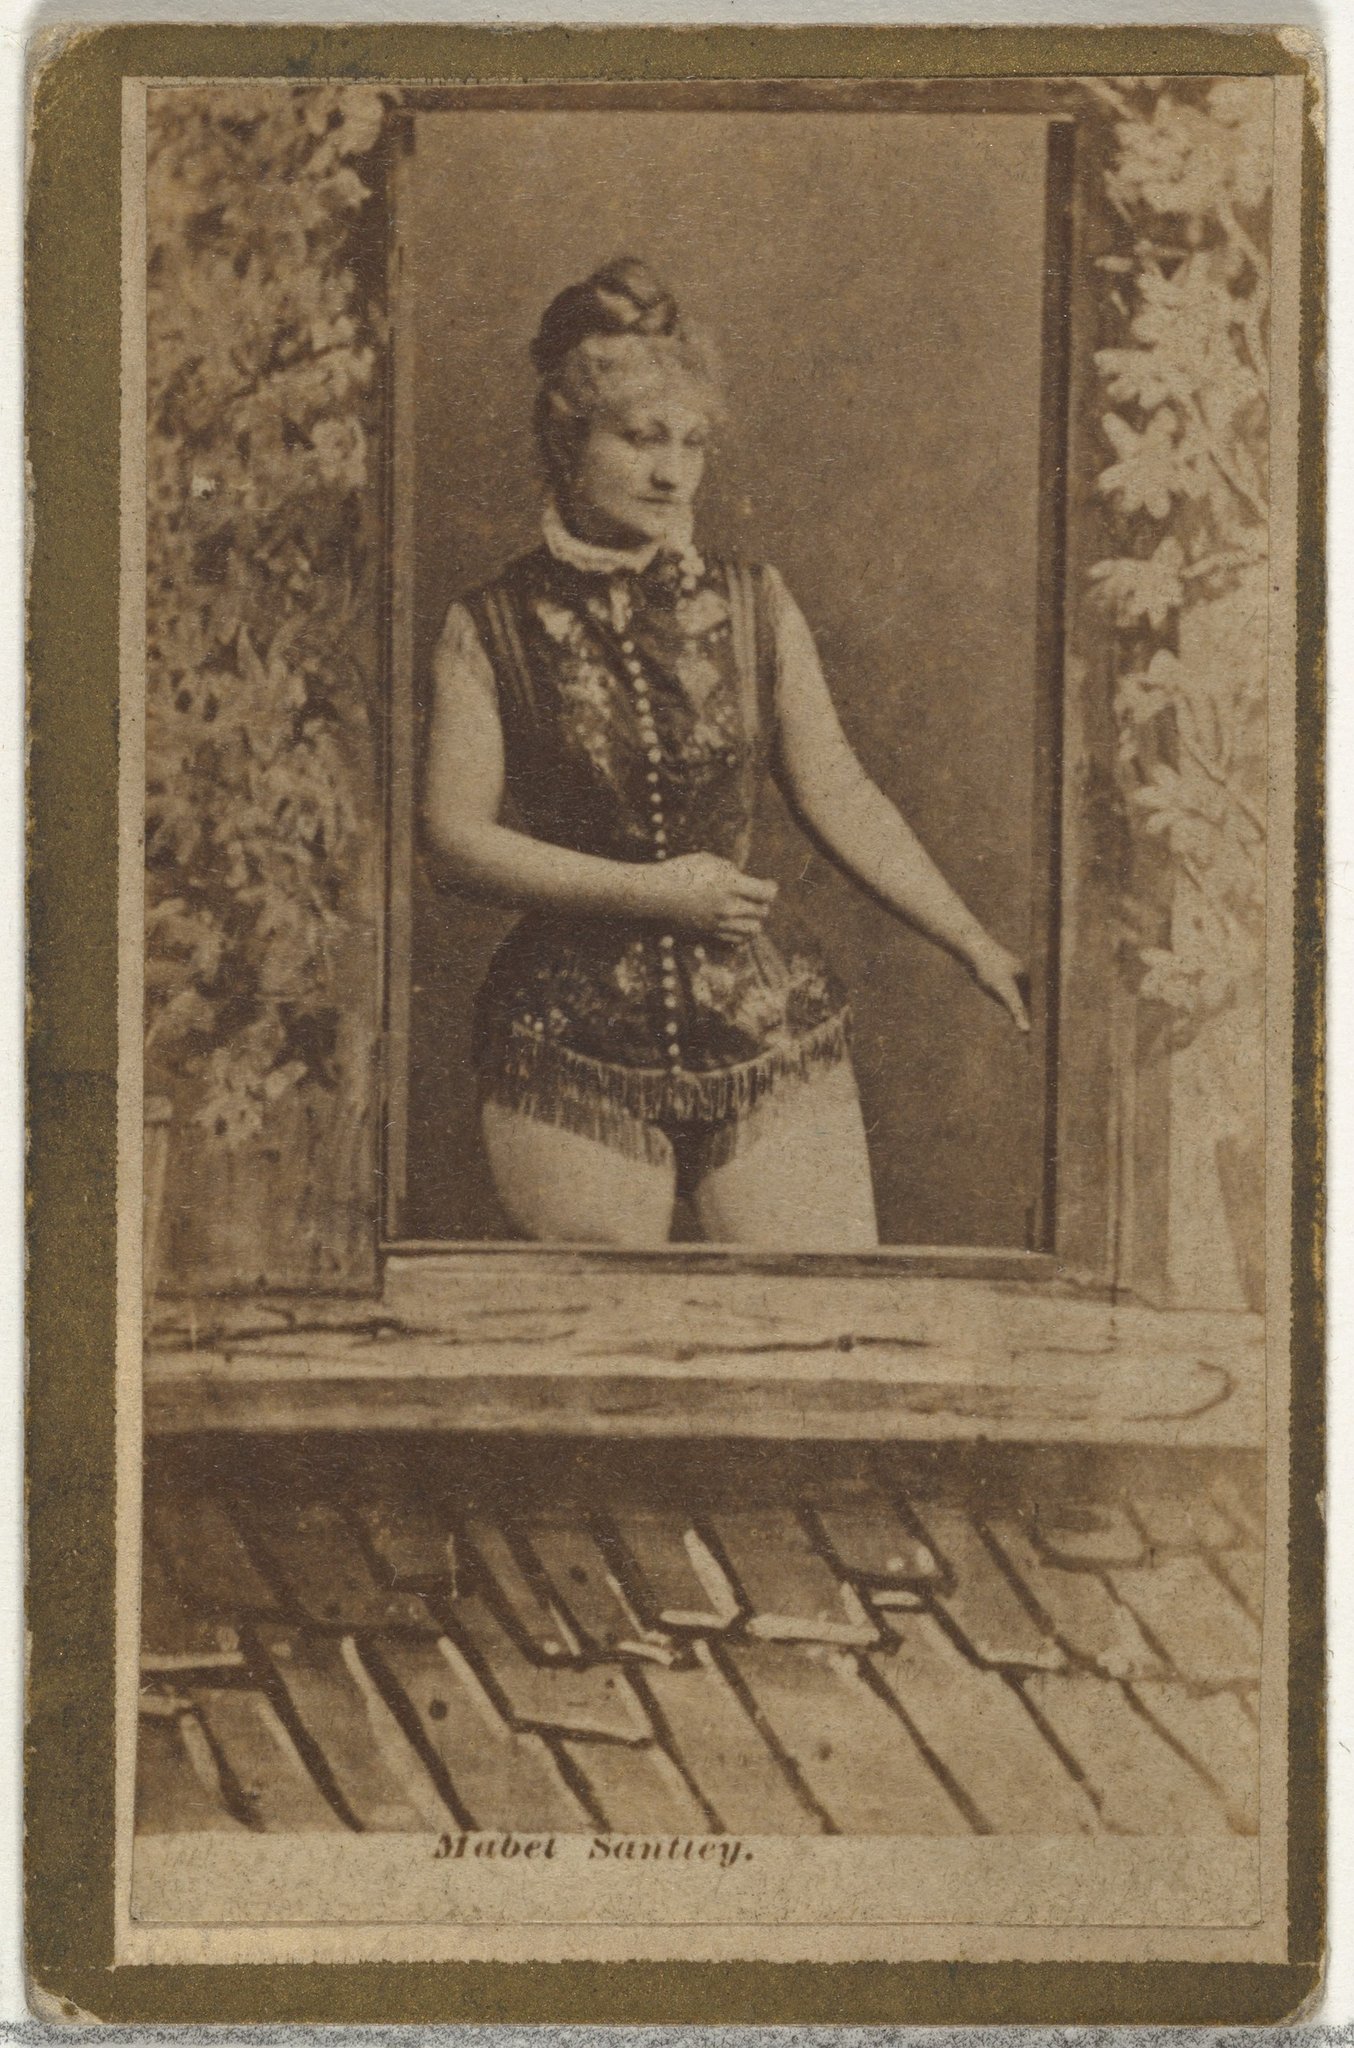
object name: photograph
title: Mabel Santley, from the Actresses and Celebrities series (N60, Type 2) promoting Little Beauties Cigarettes for Allen & Ginter brand tobacco products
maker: allen & ginter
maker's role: publisher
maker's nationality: american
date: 1887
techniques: albumen silver print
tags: portraits,women,actresses